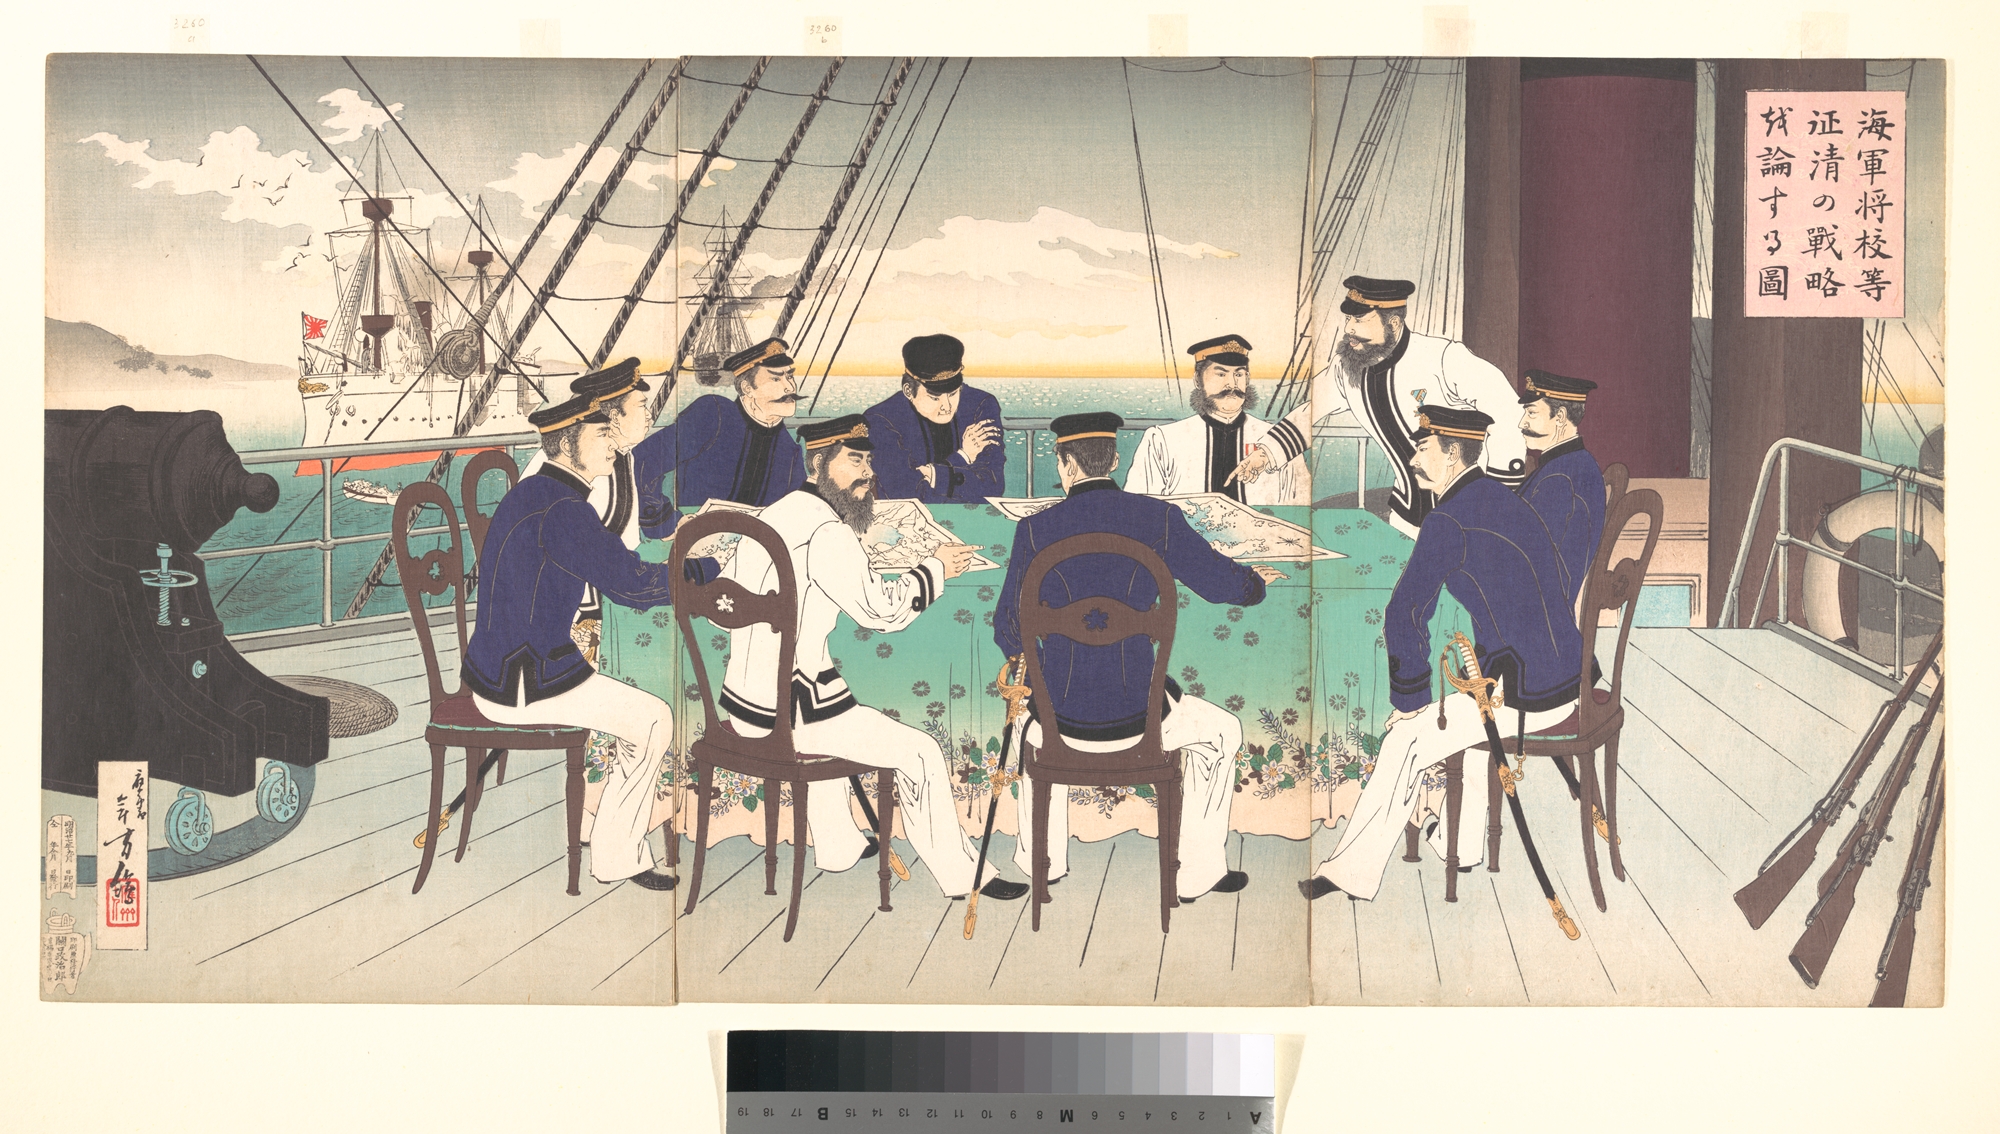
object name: print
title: Naval Officers Discussing Strategy to be Used in the War against China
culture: japanese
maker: mizuno toshikata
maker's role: artist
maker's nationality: japanese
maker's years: 1866-1908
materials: ink, paper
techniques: nishiki e, woodblock print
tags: navy,swords,men,ships